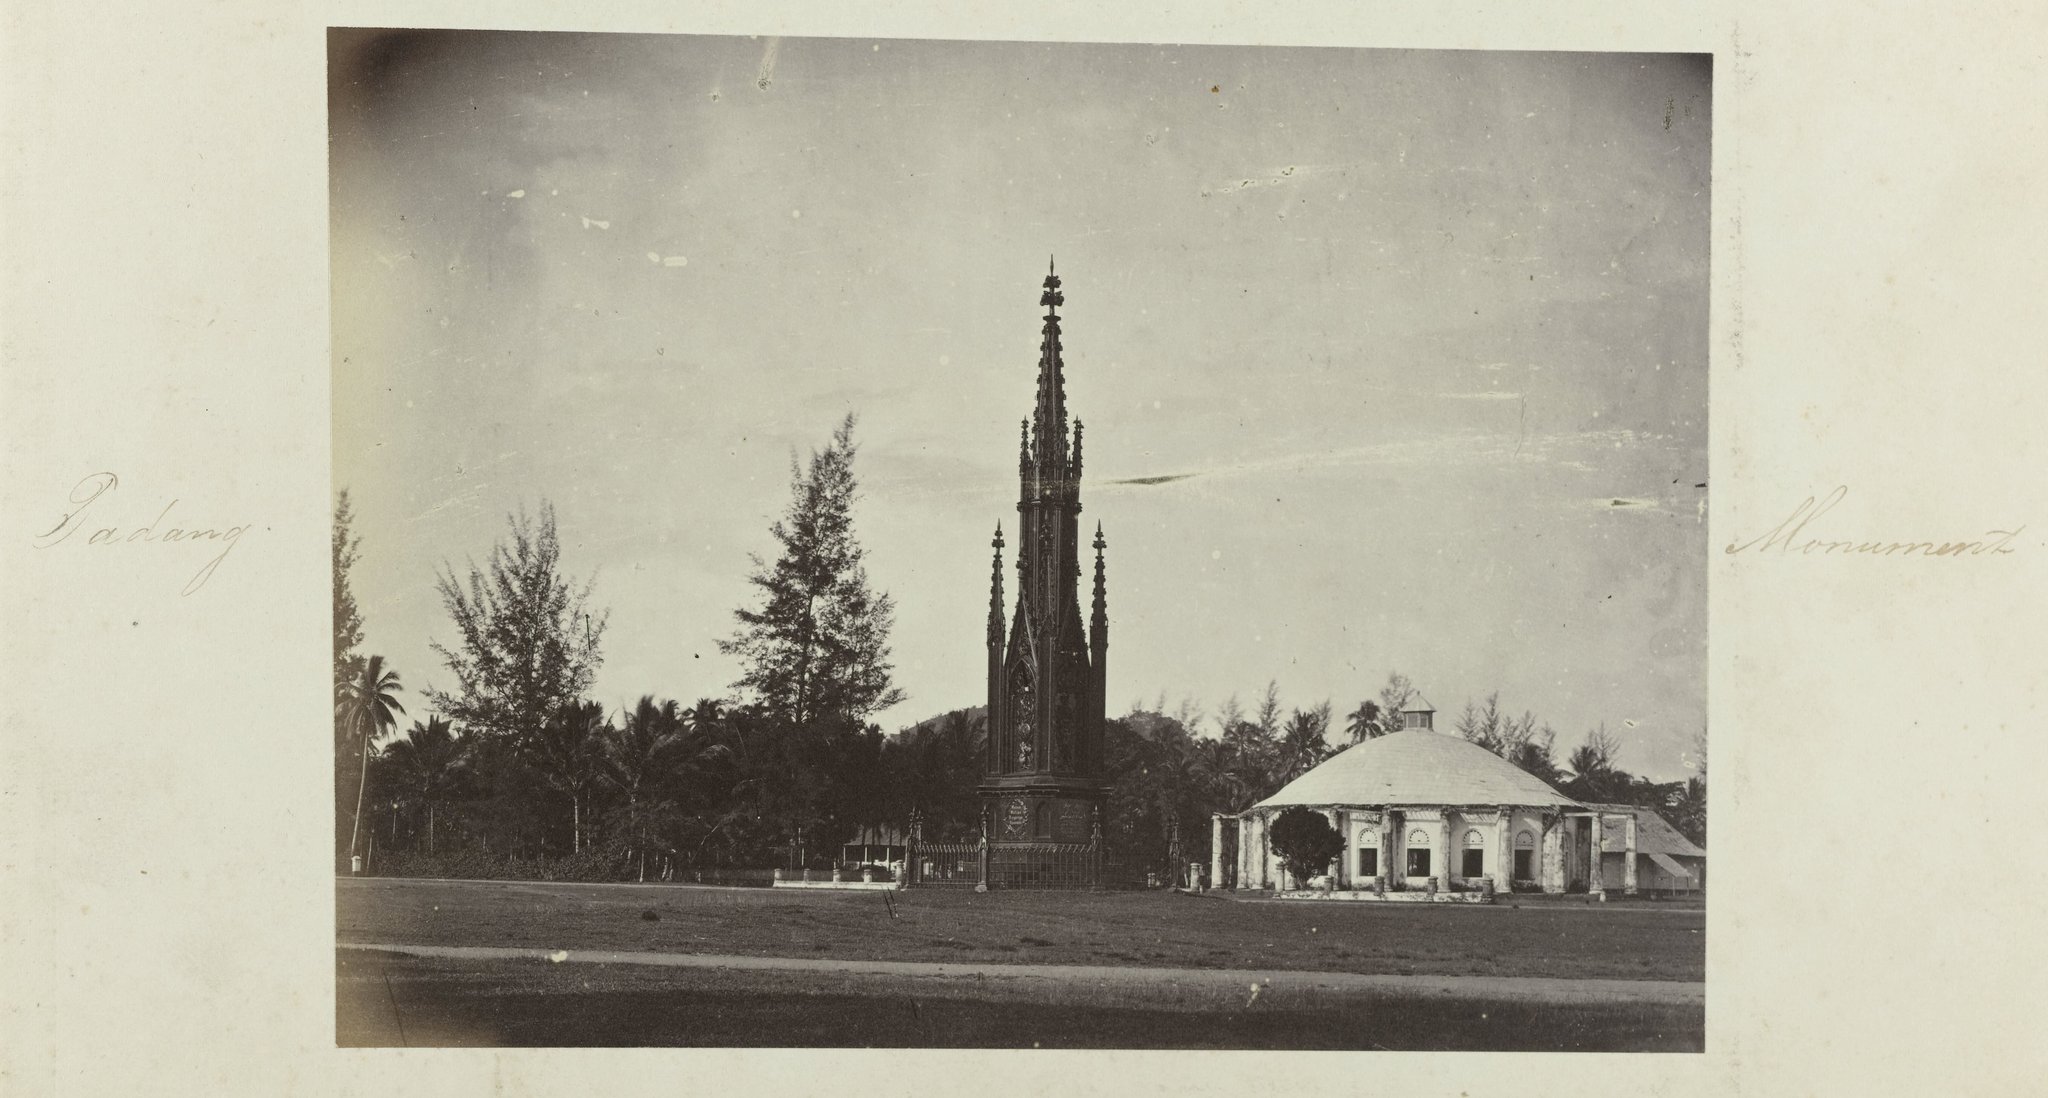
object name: photograph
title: Memorial to General Andreas Victor Michiels in Pedang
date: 1863-1869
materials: photographic support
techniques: albumen print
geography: padang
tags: maastricht, monument, statue, colonial government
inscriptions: inscription: ‘Padang. Monument’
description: Gezicht op het monument voor Generaal Michiels in Padang. Onderdeel van het groene fotoalbum met foto's van Java, uit het bezit van apotheker Specht-Grijp, die in 1865 vanuit Batavia naar Nederland terugkeerde.